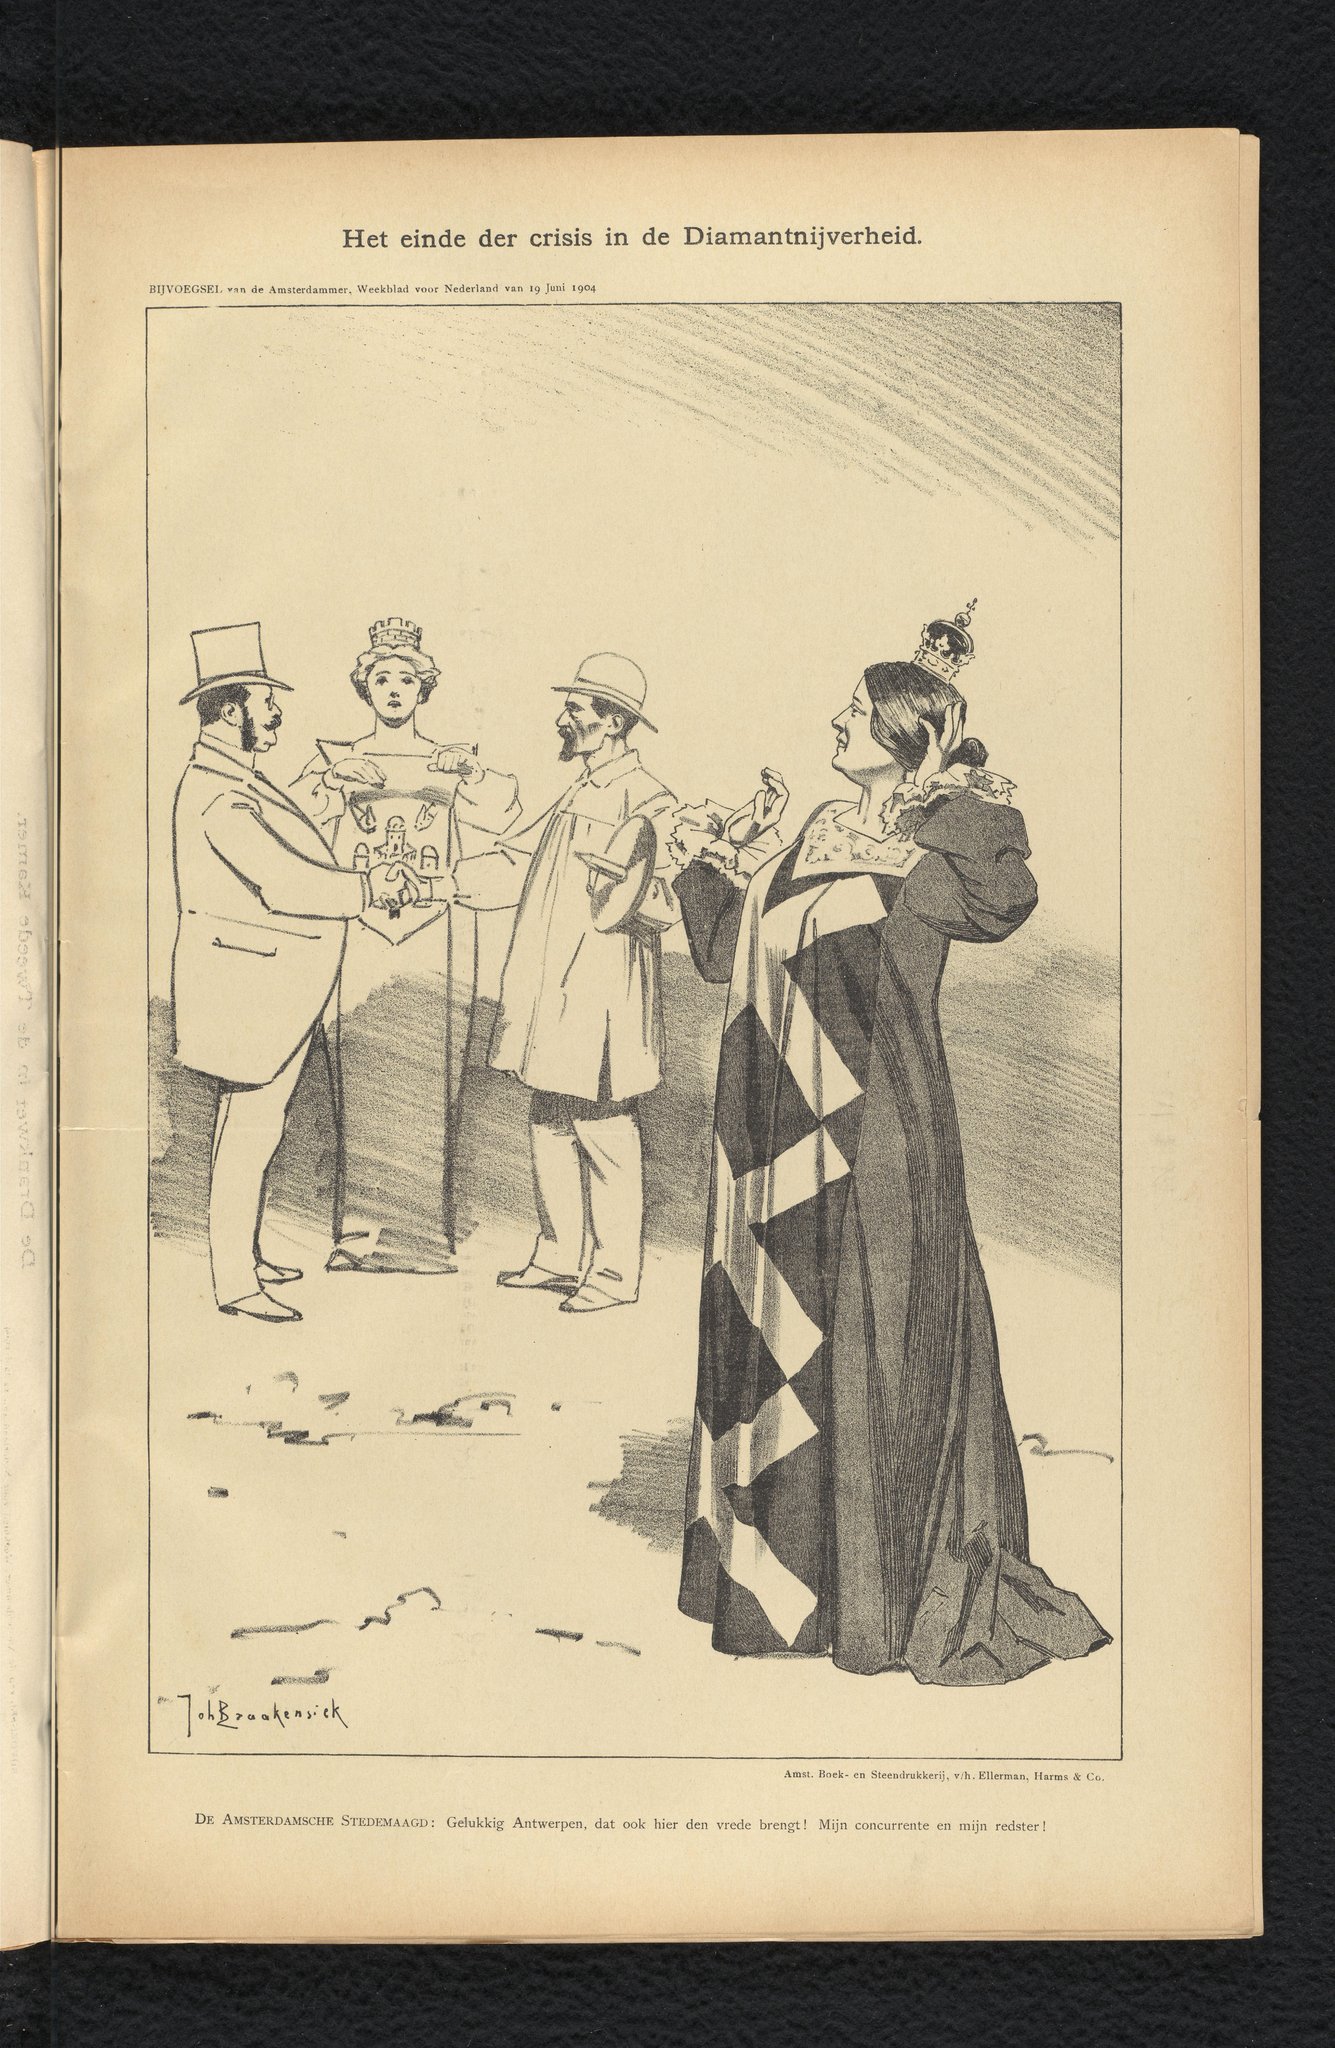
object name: cartoon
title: Het einde der crisis in de Diamantnijverheid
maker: johan braakensiek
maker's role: draughtsman, print maker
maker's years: 1858-1940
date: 1904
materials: paper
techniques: lithograph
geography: netherlands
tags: diamond polisher, diamond cutter, personification of a city, town-patron(ess), political caricatures and satires, antwerp, amsterdam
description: De stedenmaagden van Amsterdam en Antwerpen overzien het sluiten van vrede tussen de concurrerende diamantindustrieën in beide steden.